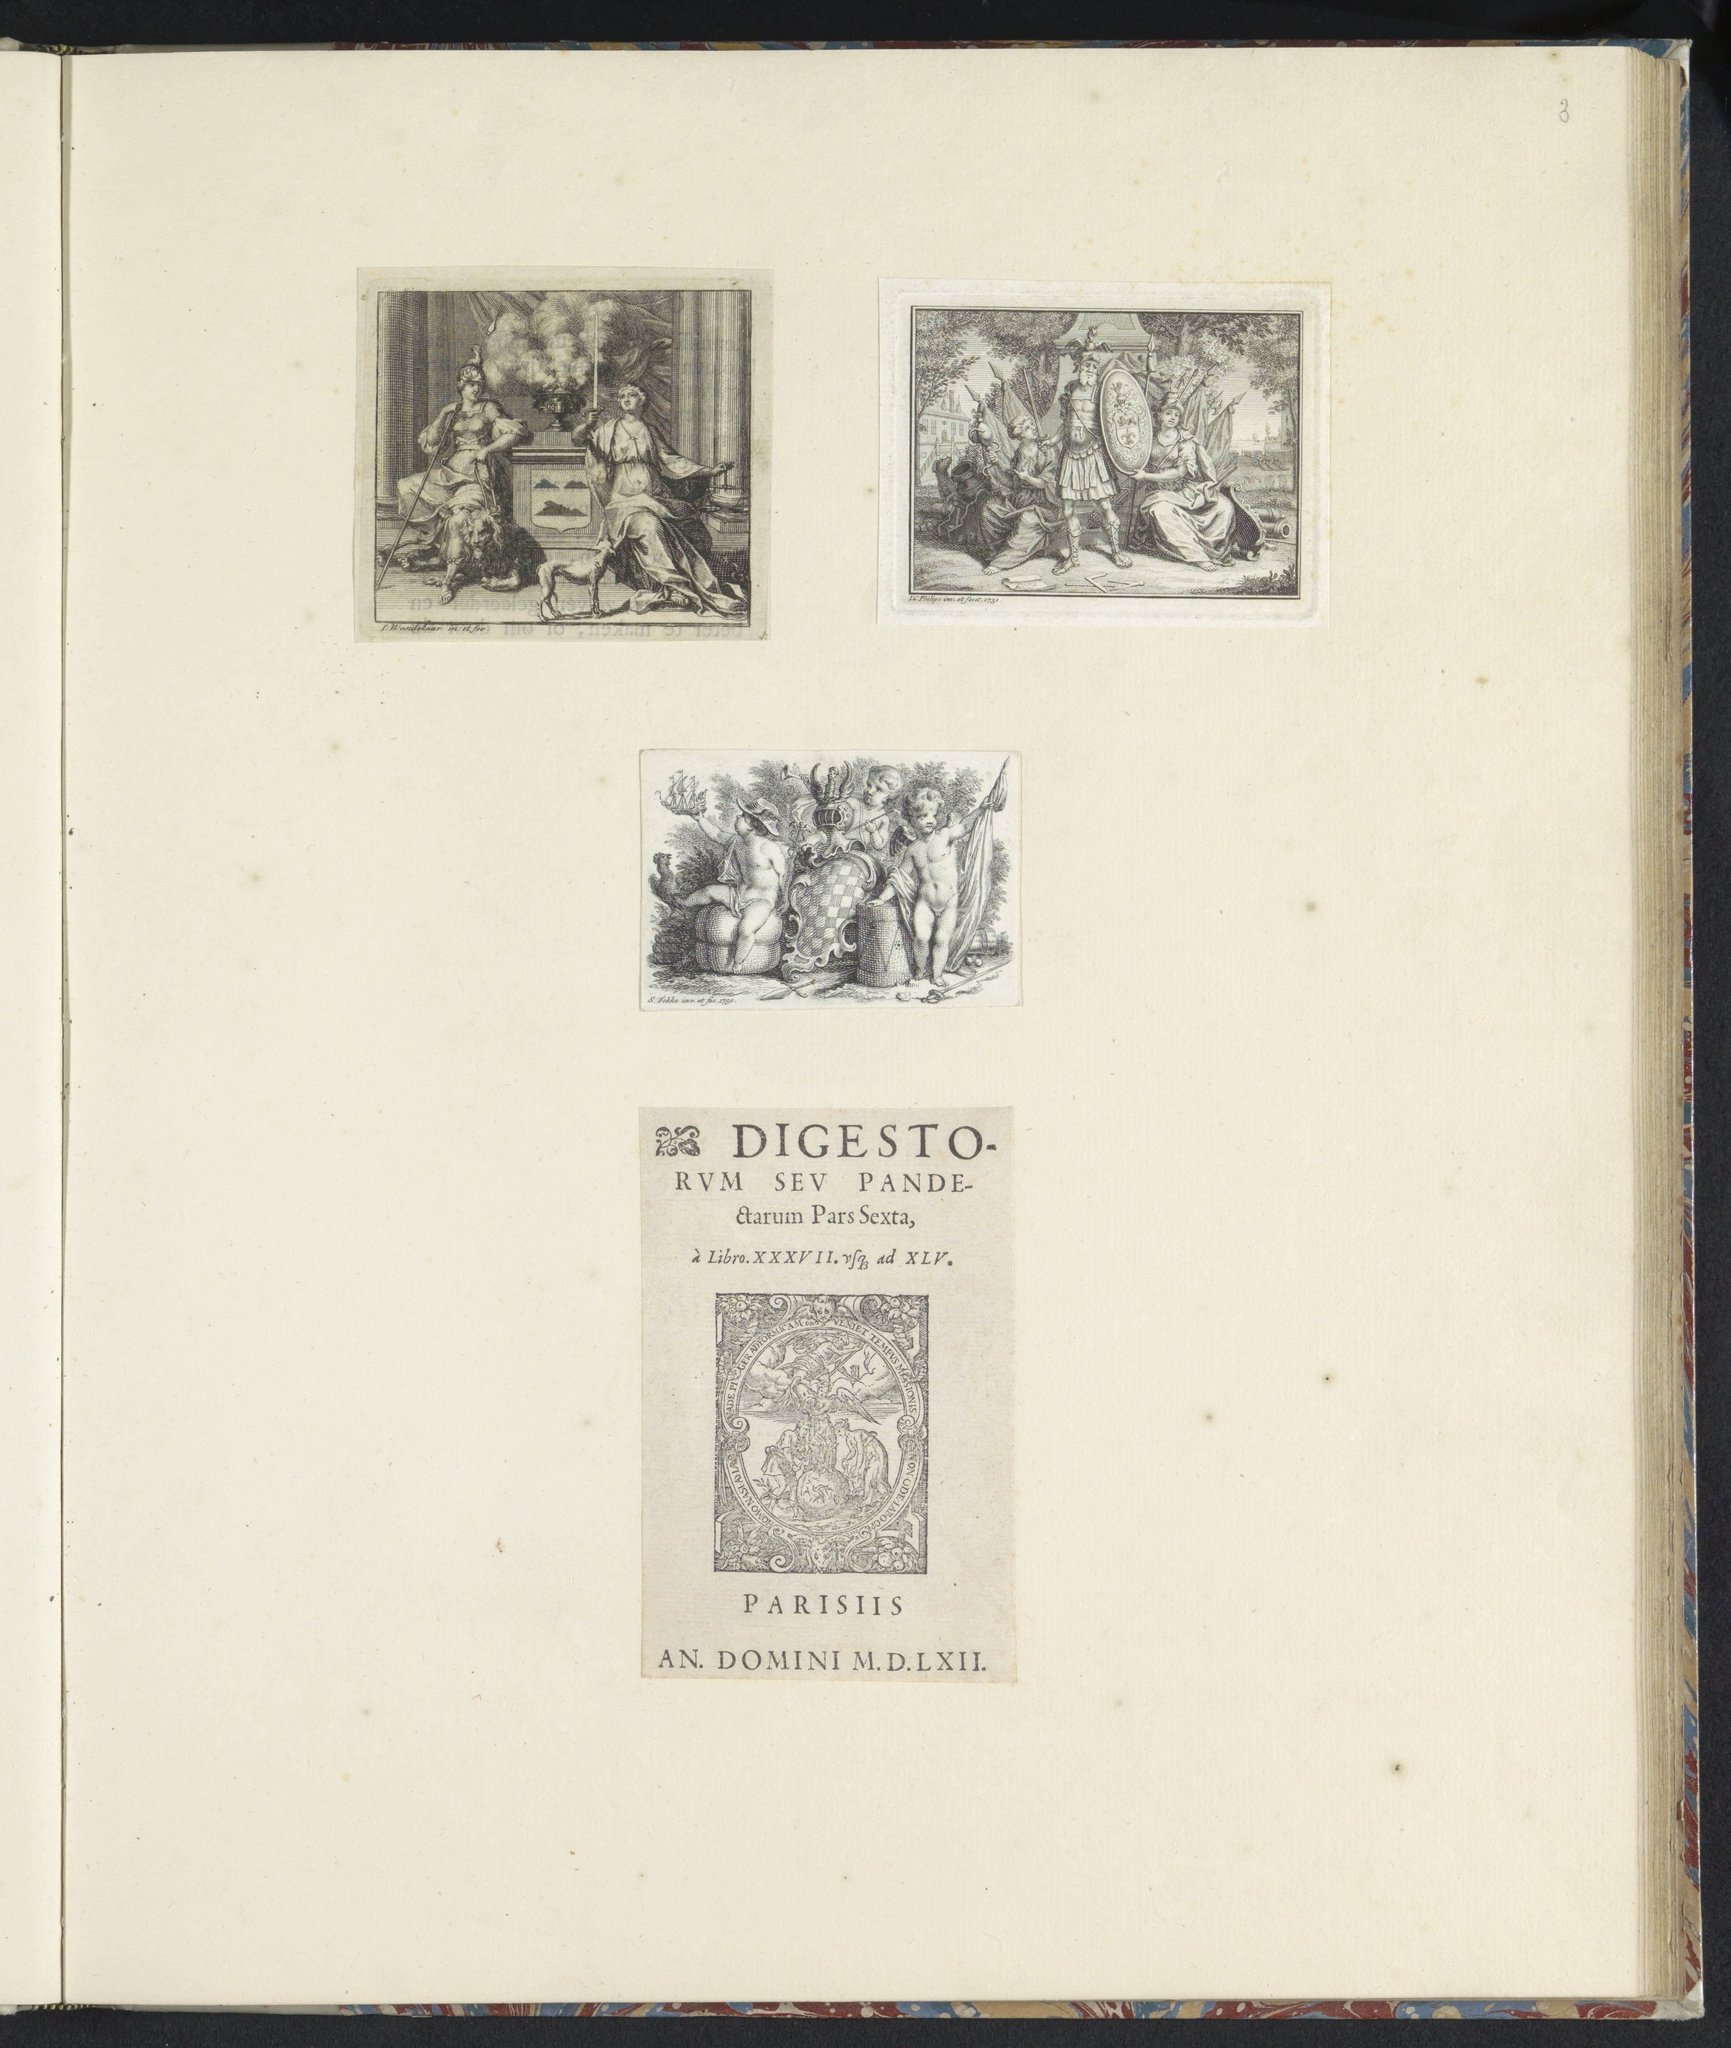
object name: titelblad, titelpagina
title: Vier vignetten met wapenschilden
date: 1562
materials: paper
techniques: engraving, etching, letterpress printing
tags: vignette, armorial bearing, heraldry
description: Vier voorstellingen op een albumblad. Bovenaan twee voorstellingen met een wapenschild, beide geflankeerd door personificaties. In het midden een wapenschild omgeven door putti. Eén van de putti steekt een model van een schip in de lucht en heeft een caduceus in de handen. De tweede blaast op een trompet en een derde staat met een trommel en een vaandel. Onderaan het titelvignet van de Parijse boekverkoper Guillaume Merlin. Drie personen bewerken het land en zorgen voor de planten van de wereld. Daarbij Vader Tijd. De prenten maken deel uit van een album.